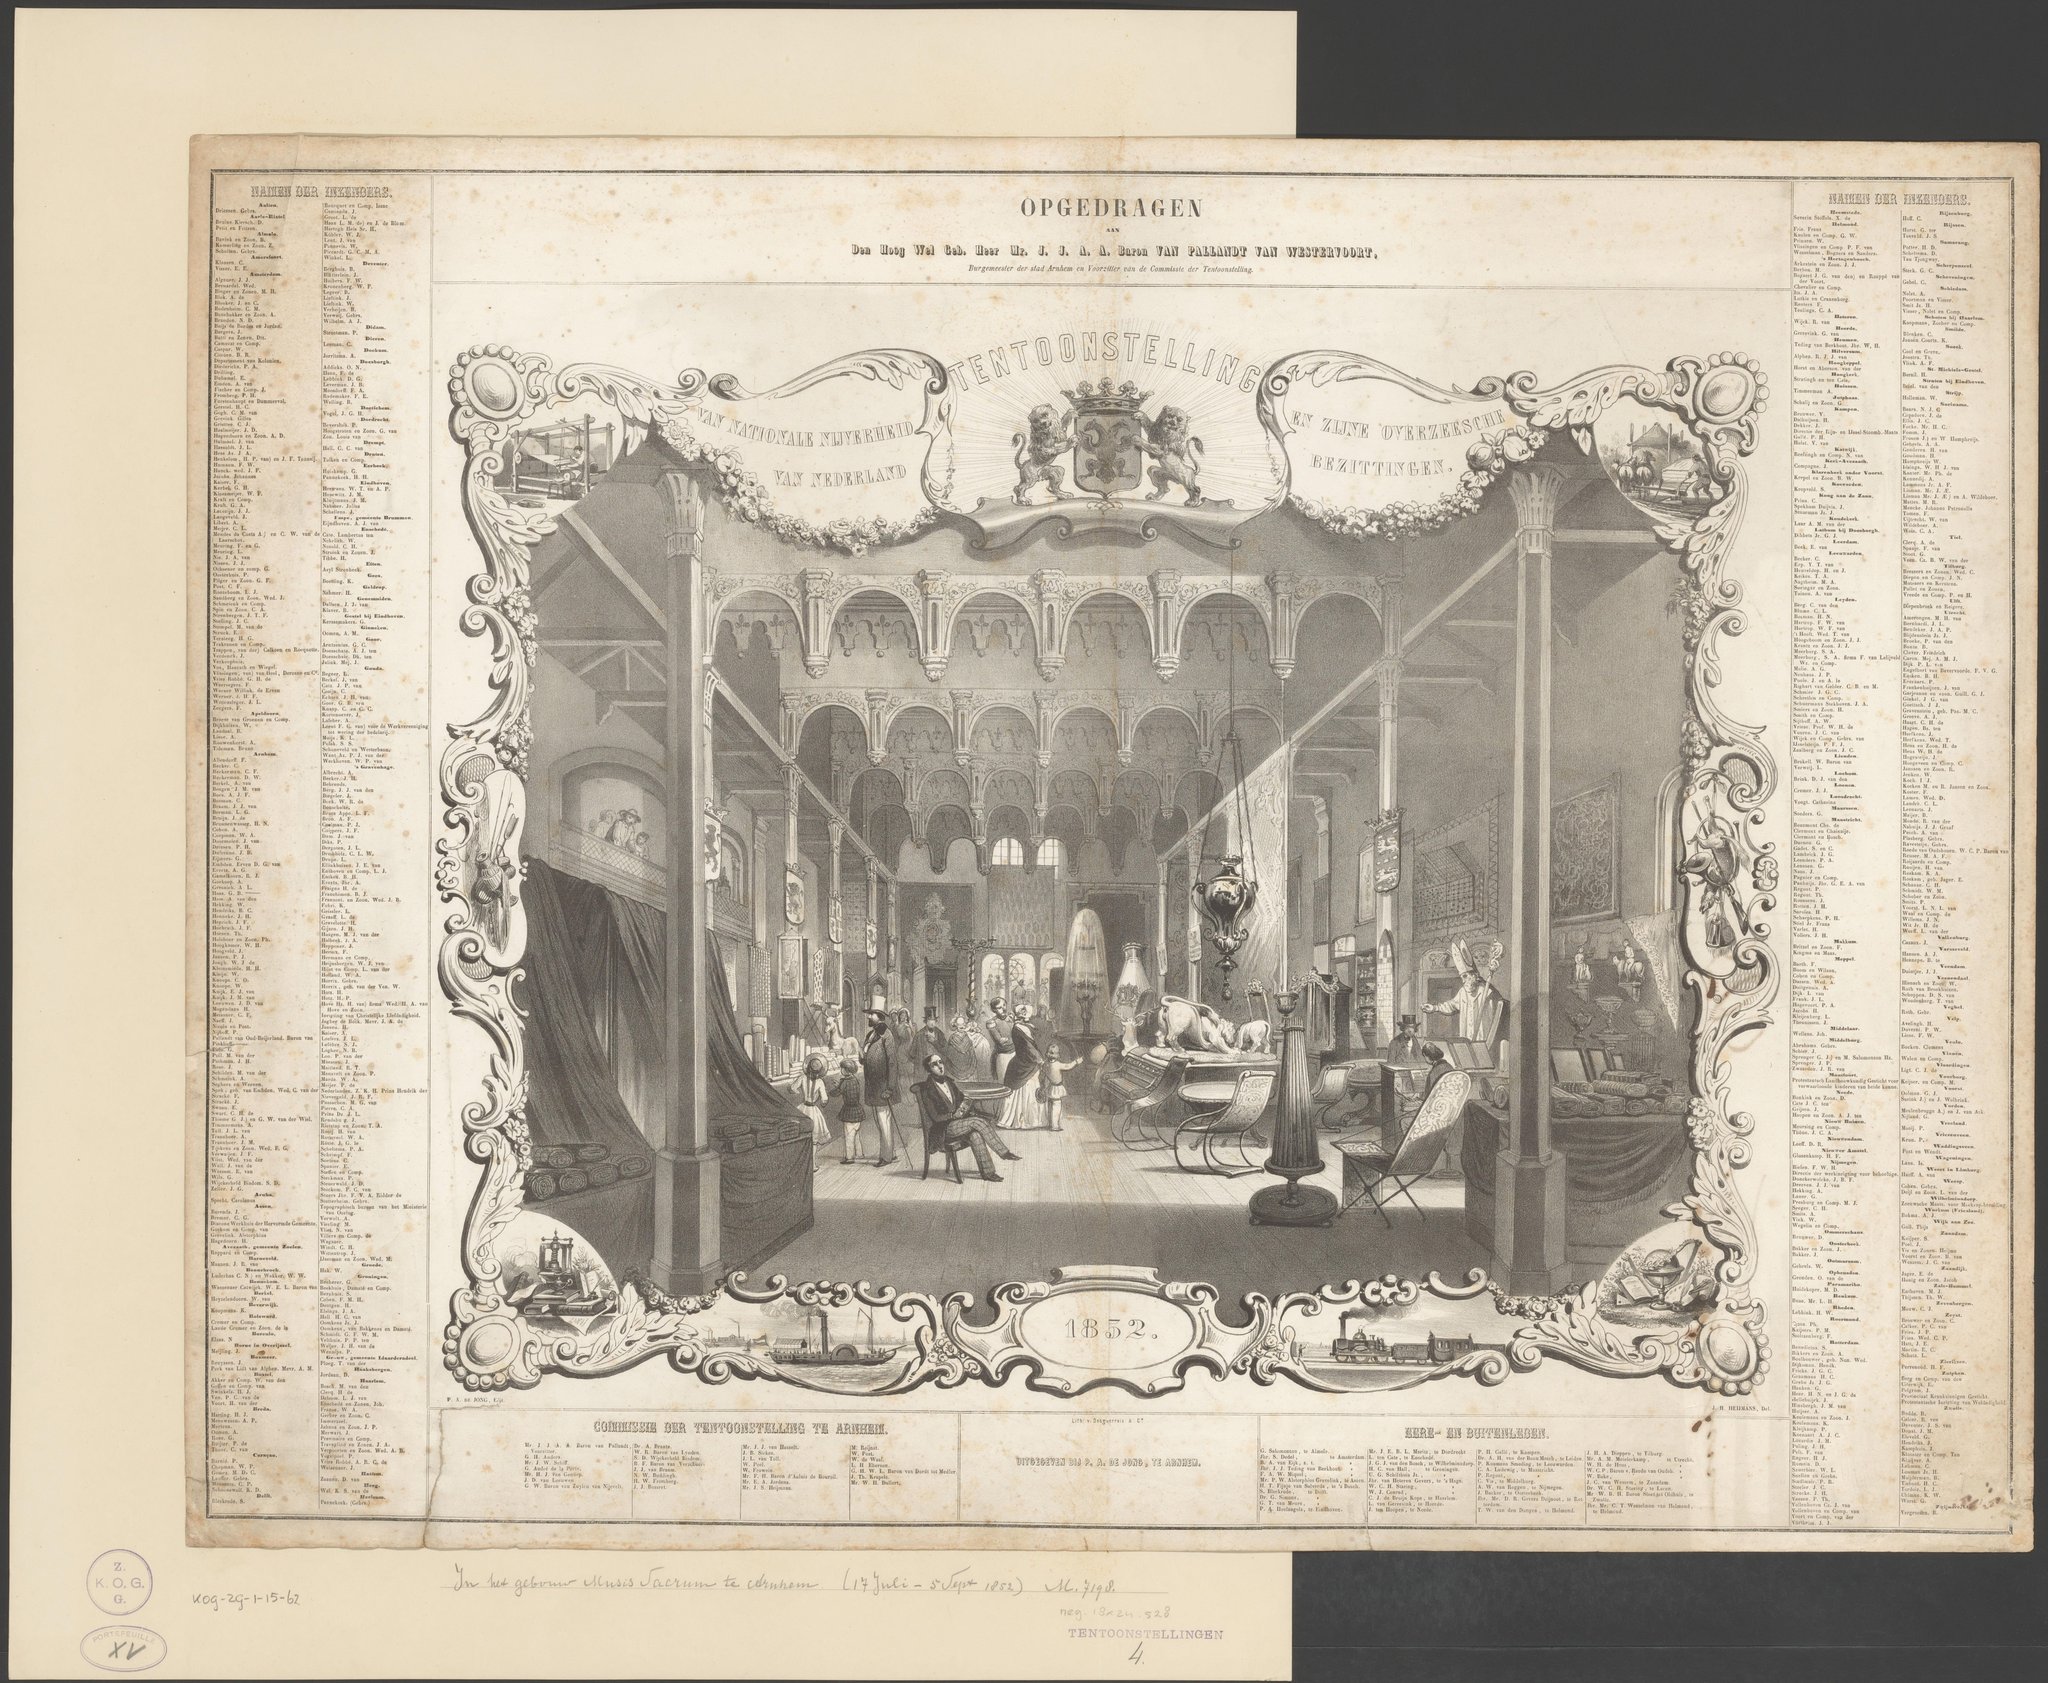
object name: print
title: Tentoonstelling van Nationale Nijverheid van Nederland en zijne overzeesche bezittingen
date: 1852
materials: paper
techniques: letterpress printing, lithograph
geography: amsterdam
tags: trade exhibition, industries fair, arnhem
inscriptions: stamp, collector's mark: Lugt 1641, stamp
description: Gezicht in een zaal van de Tentoonstelling van Nationale Nijverheid van Nederland en Overzeese gebieden, gehouden in het gebouw Musis Sacrum te Arnhem, 17 juli - 5 september 1852. In een omlijsting versierd met het wapen van Arnhem, vignetten met attributen van landbouw, nijverheid, kunsten en wetenschappen, een stoomschip en een stoomlocomotief. Links en rechts lijsten met de namen van de inzenders, onderaan de namen van de commissieleden. Onderwerpsrubrieken binnen de Atlas Zeden en Gewoonten: Handel, nijverheid en verkeer, Tentoonstellingen.